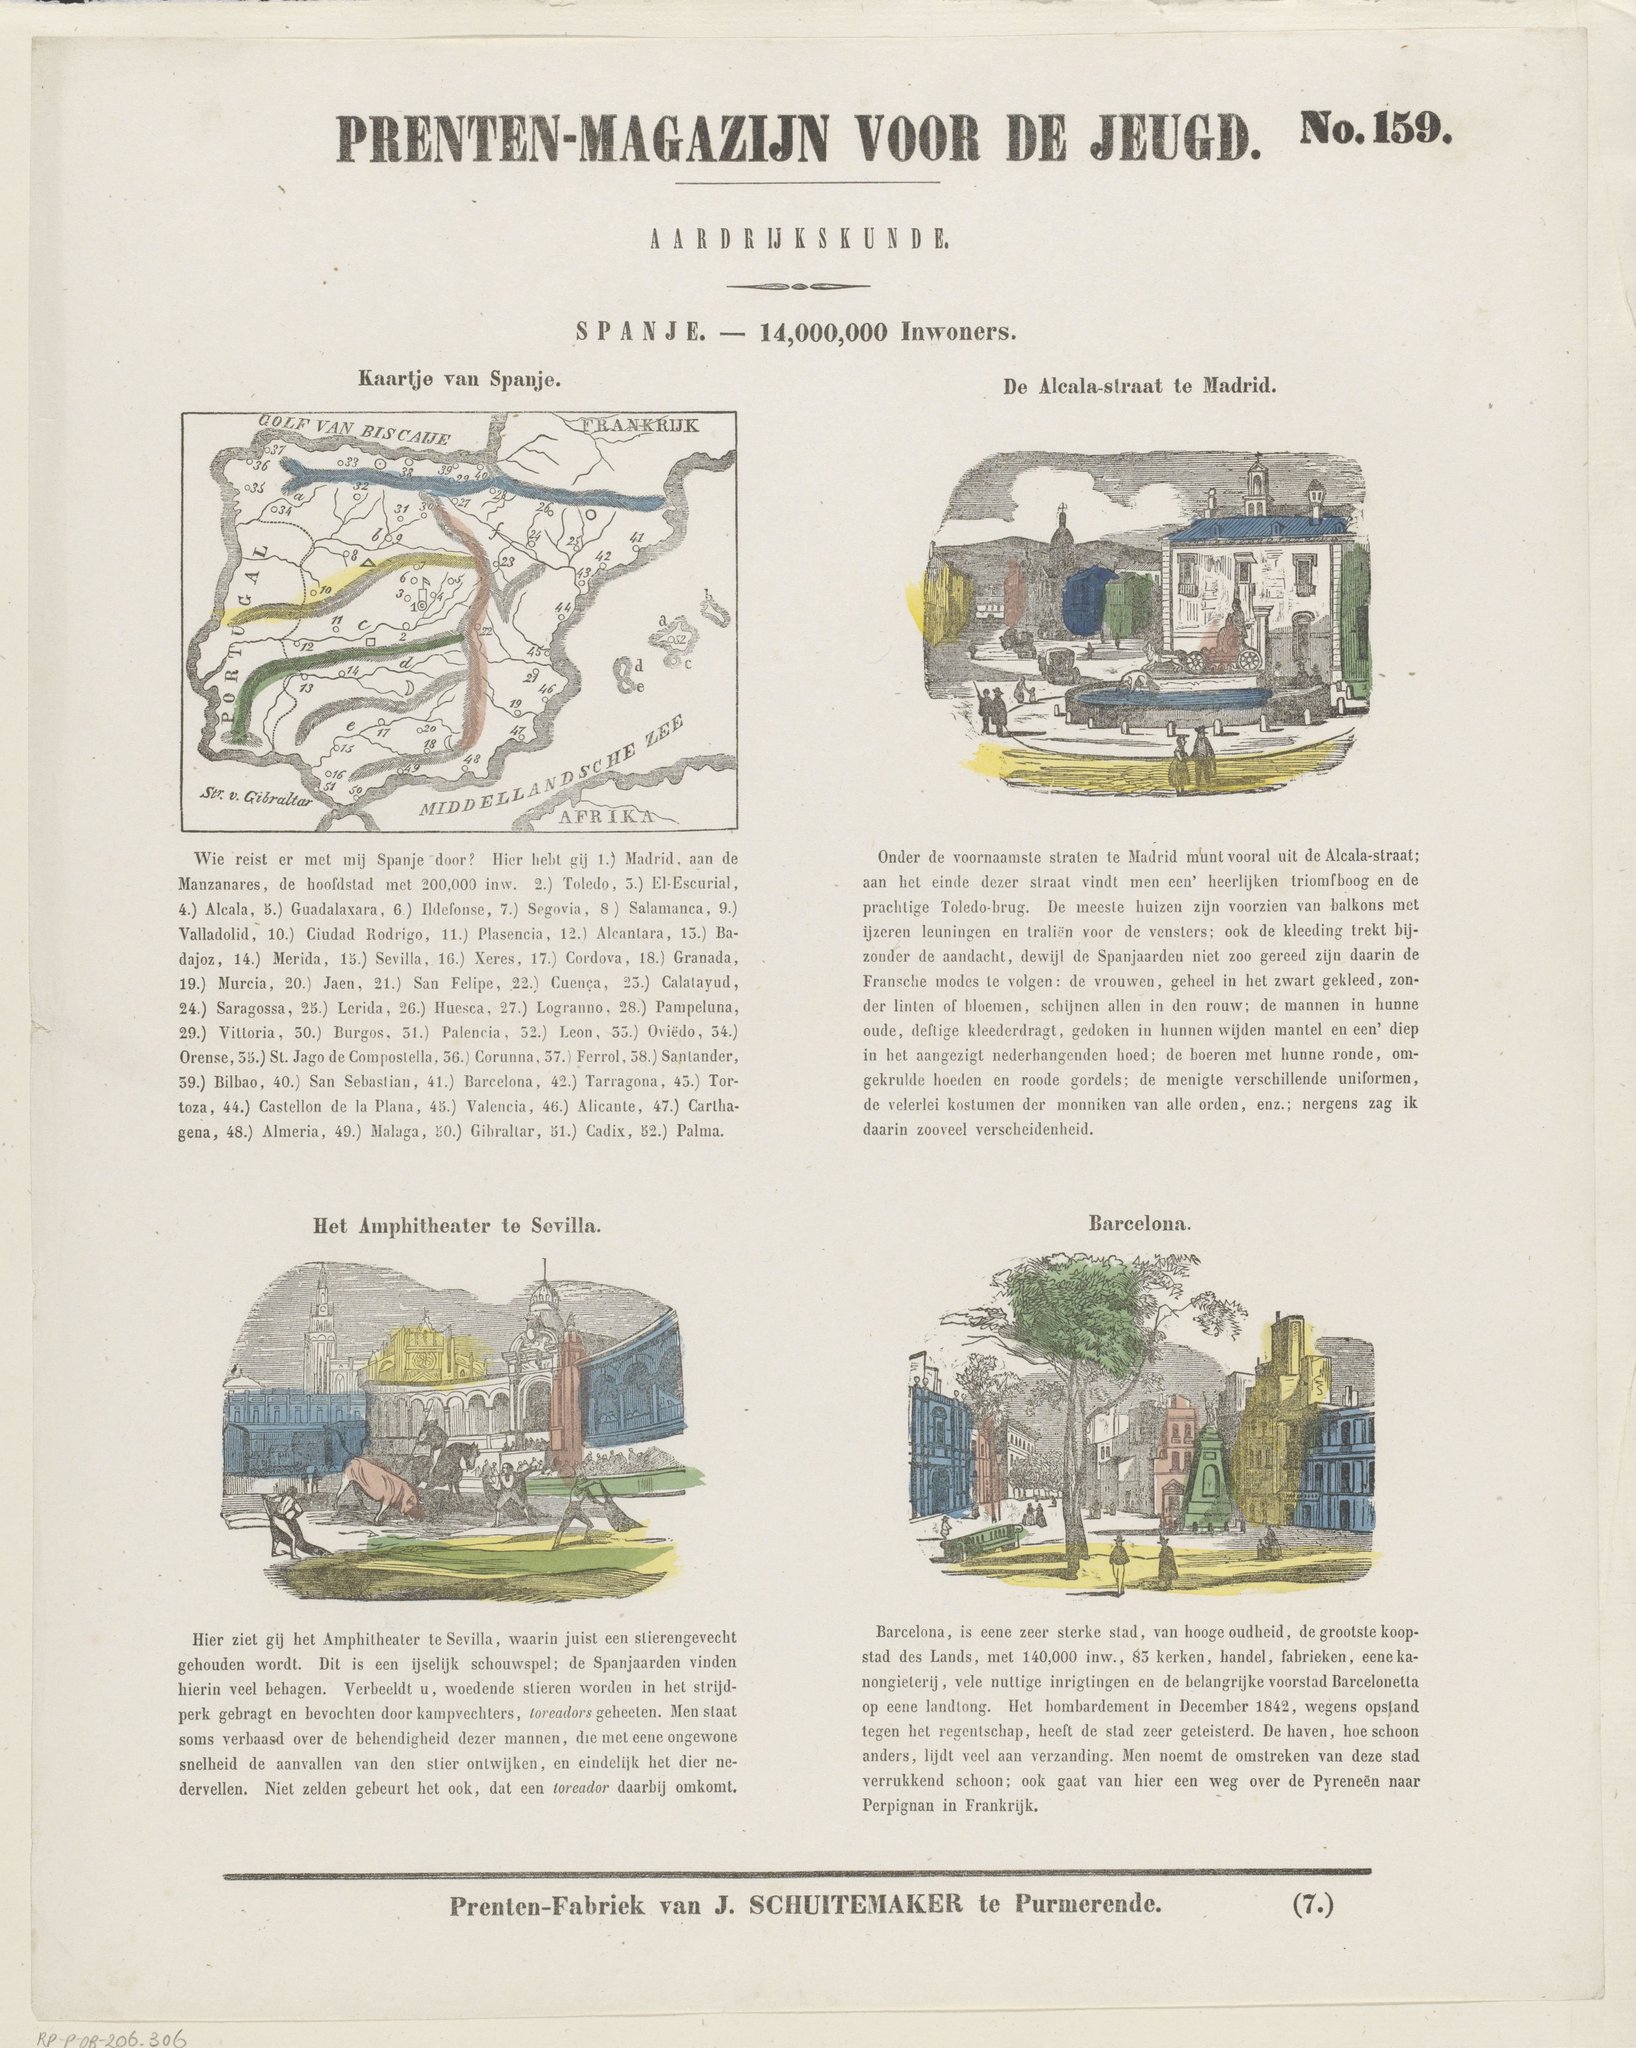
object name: print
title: Aardrijkskunde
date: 1850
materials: paper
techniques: colour, letterpress printing, engraving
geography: netherlands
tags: buildings for performances, maps, atlases, sevilla, spain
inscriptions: collector's mark: Lugt 2760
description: Na voltooiing van de acht jaargangen van de reeks 'Prenten-magazijn voor de jeugd' in 1850 heeft Jan Schuitemaker al deze prenten heruitgegeven en omgenummerd als nr. 1 t/m 192. De oorspronkelijke jaargang wordt telkens nog vermeld rechtsonder op de prent. Binnen de jaargangen zijn prenten van hetzelfde thema in clusters van vier achter elkaar gezet.